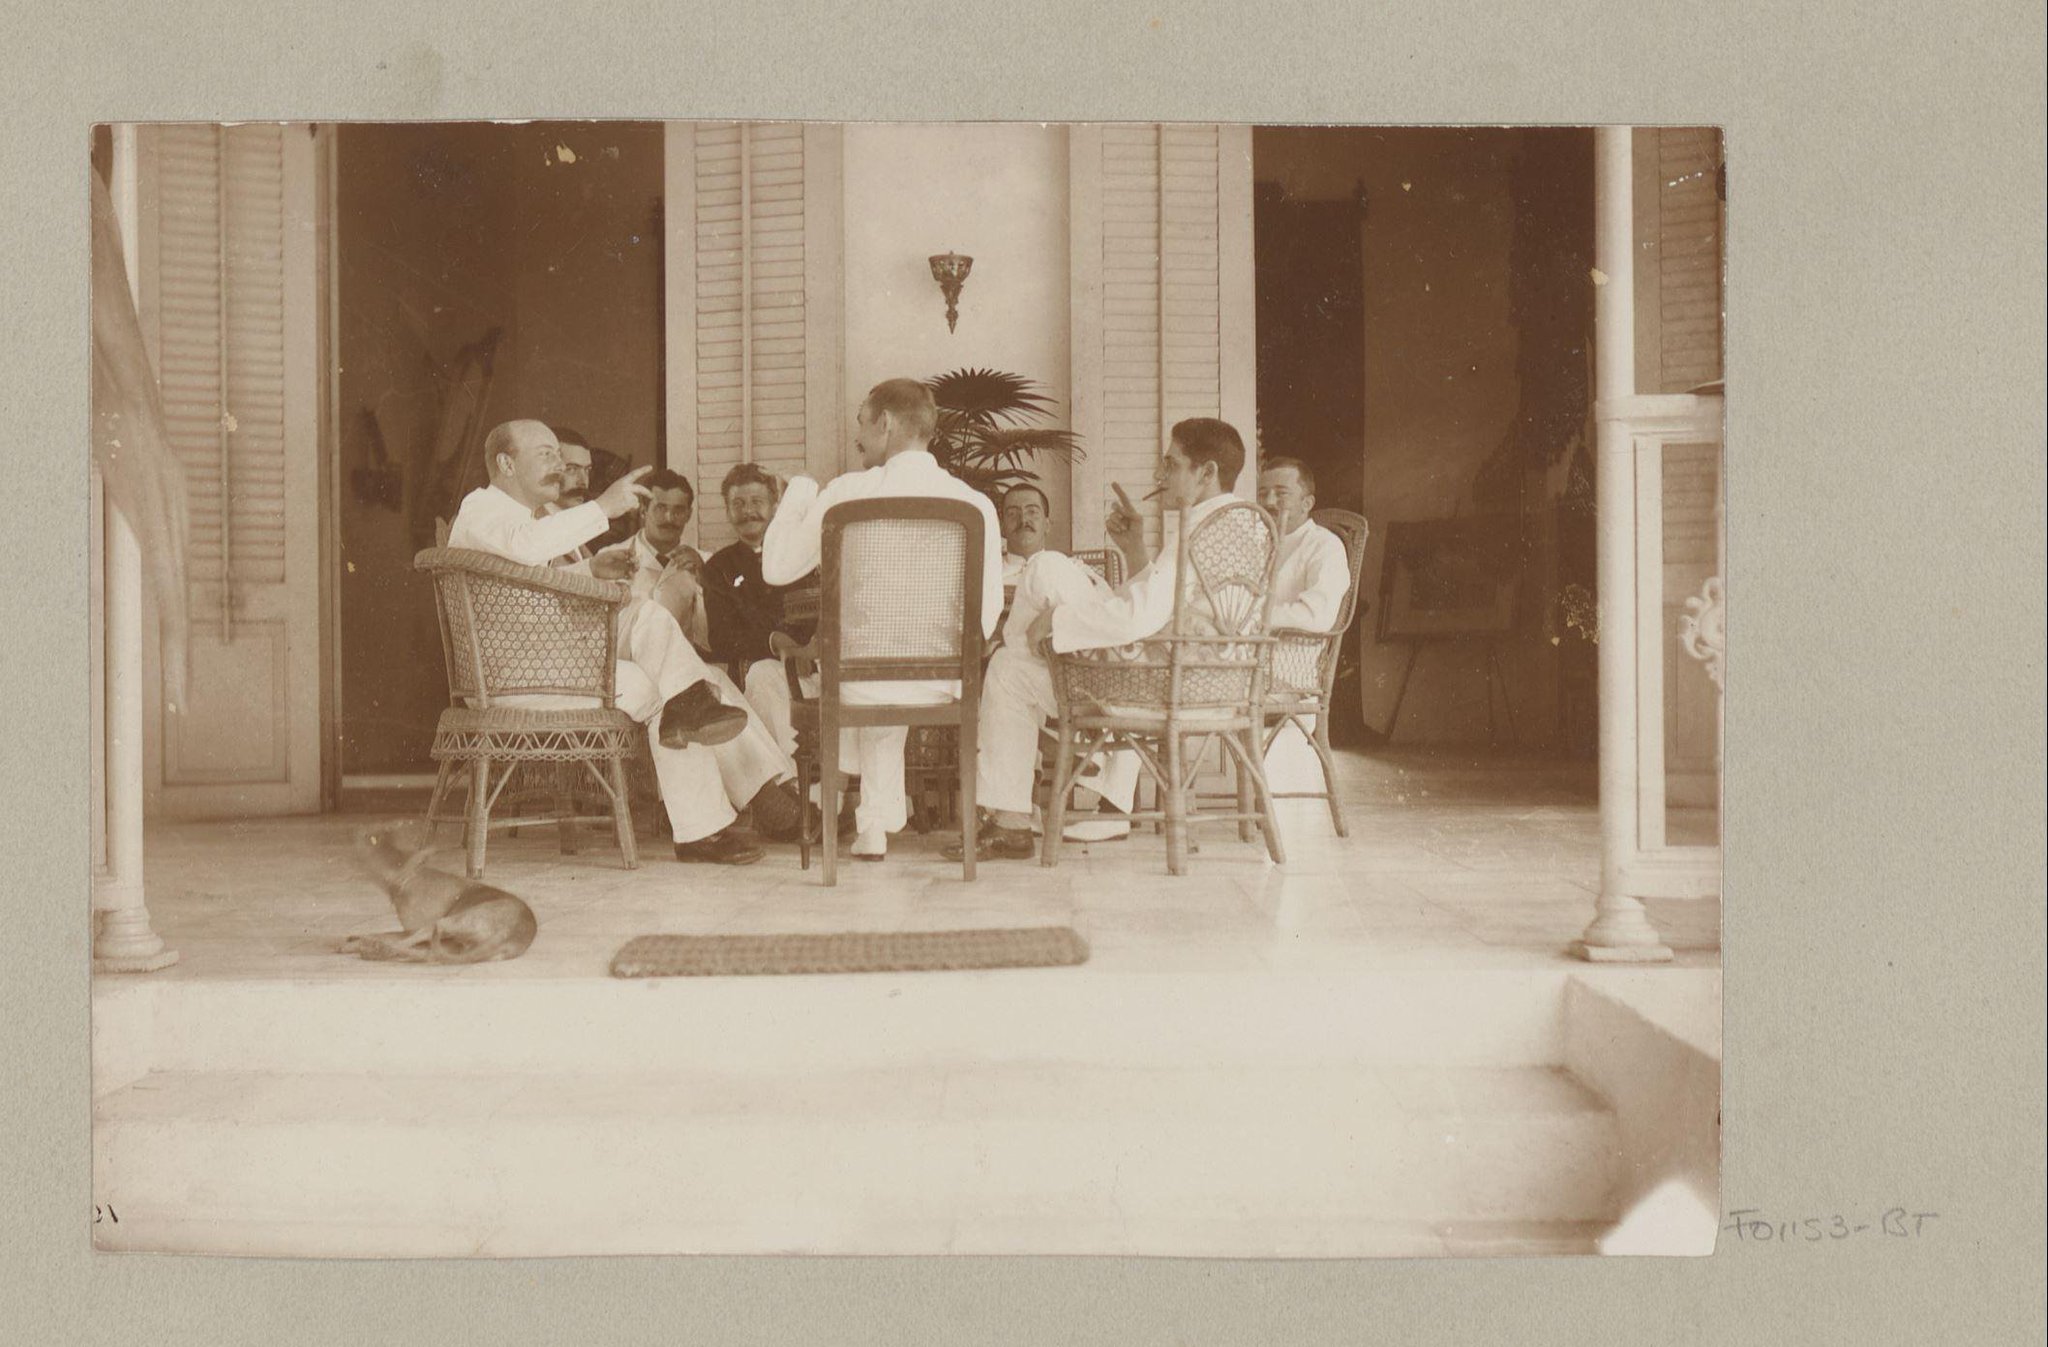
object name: album leaf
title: Europese mannen aan tafel op een veranda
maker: Anonymous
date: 1880-1900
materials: photographic support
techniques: collodion silver print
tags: europeans, adult man, dutch east indies, the